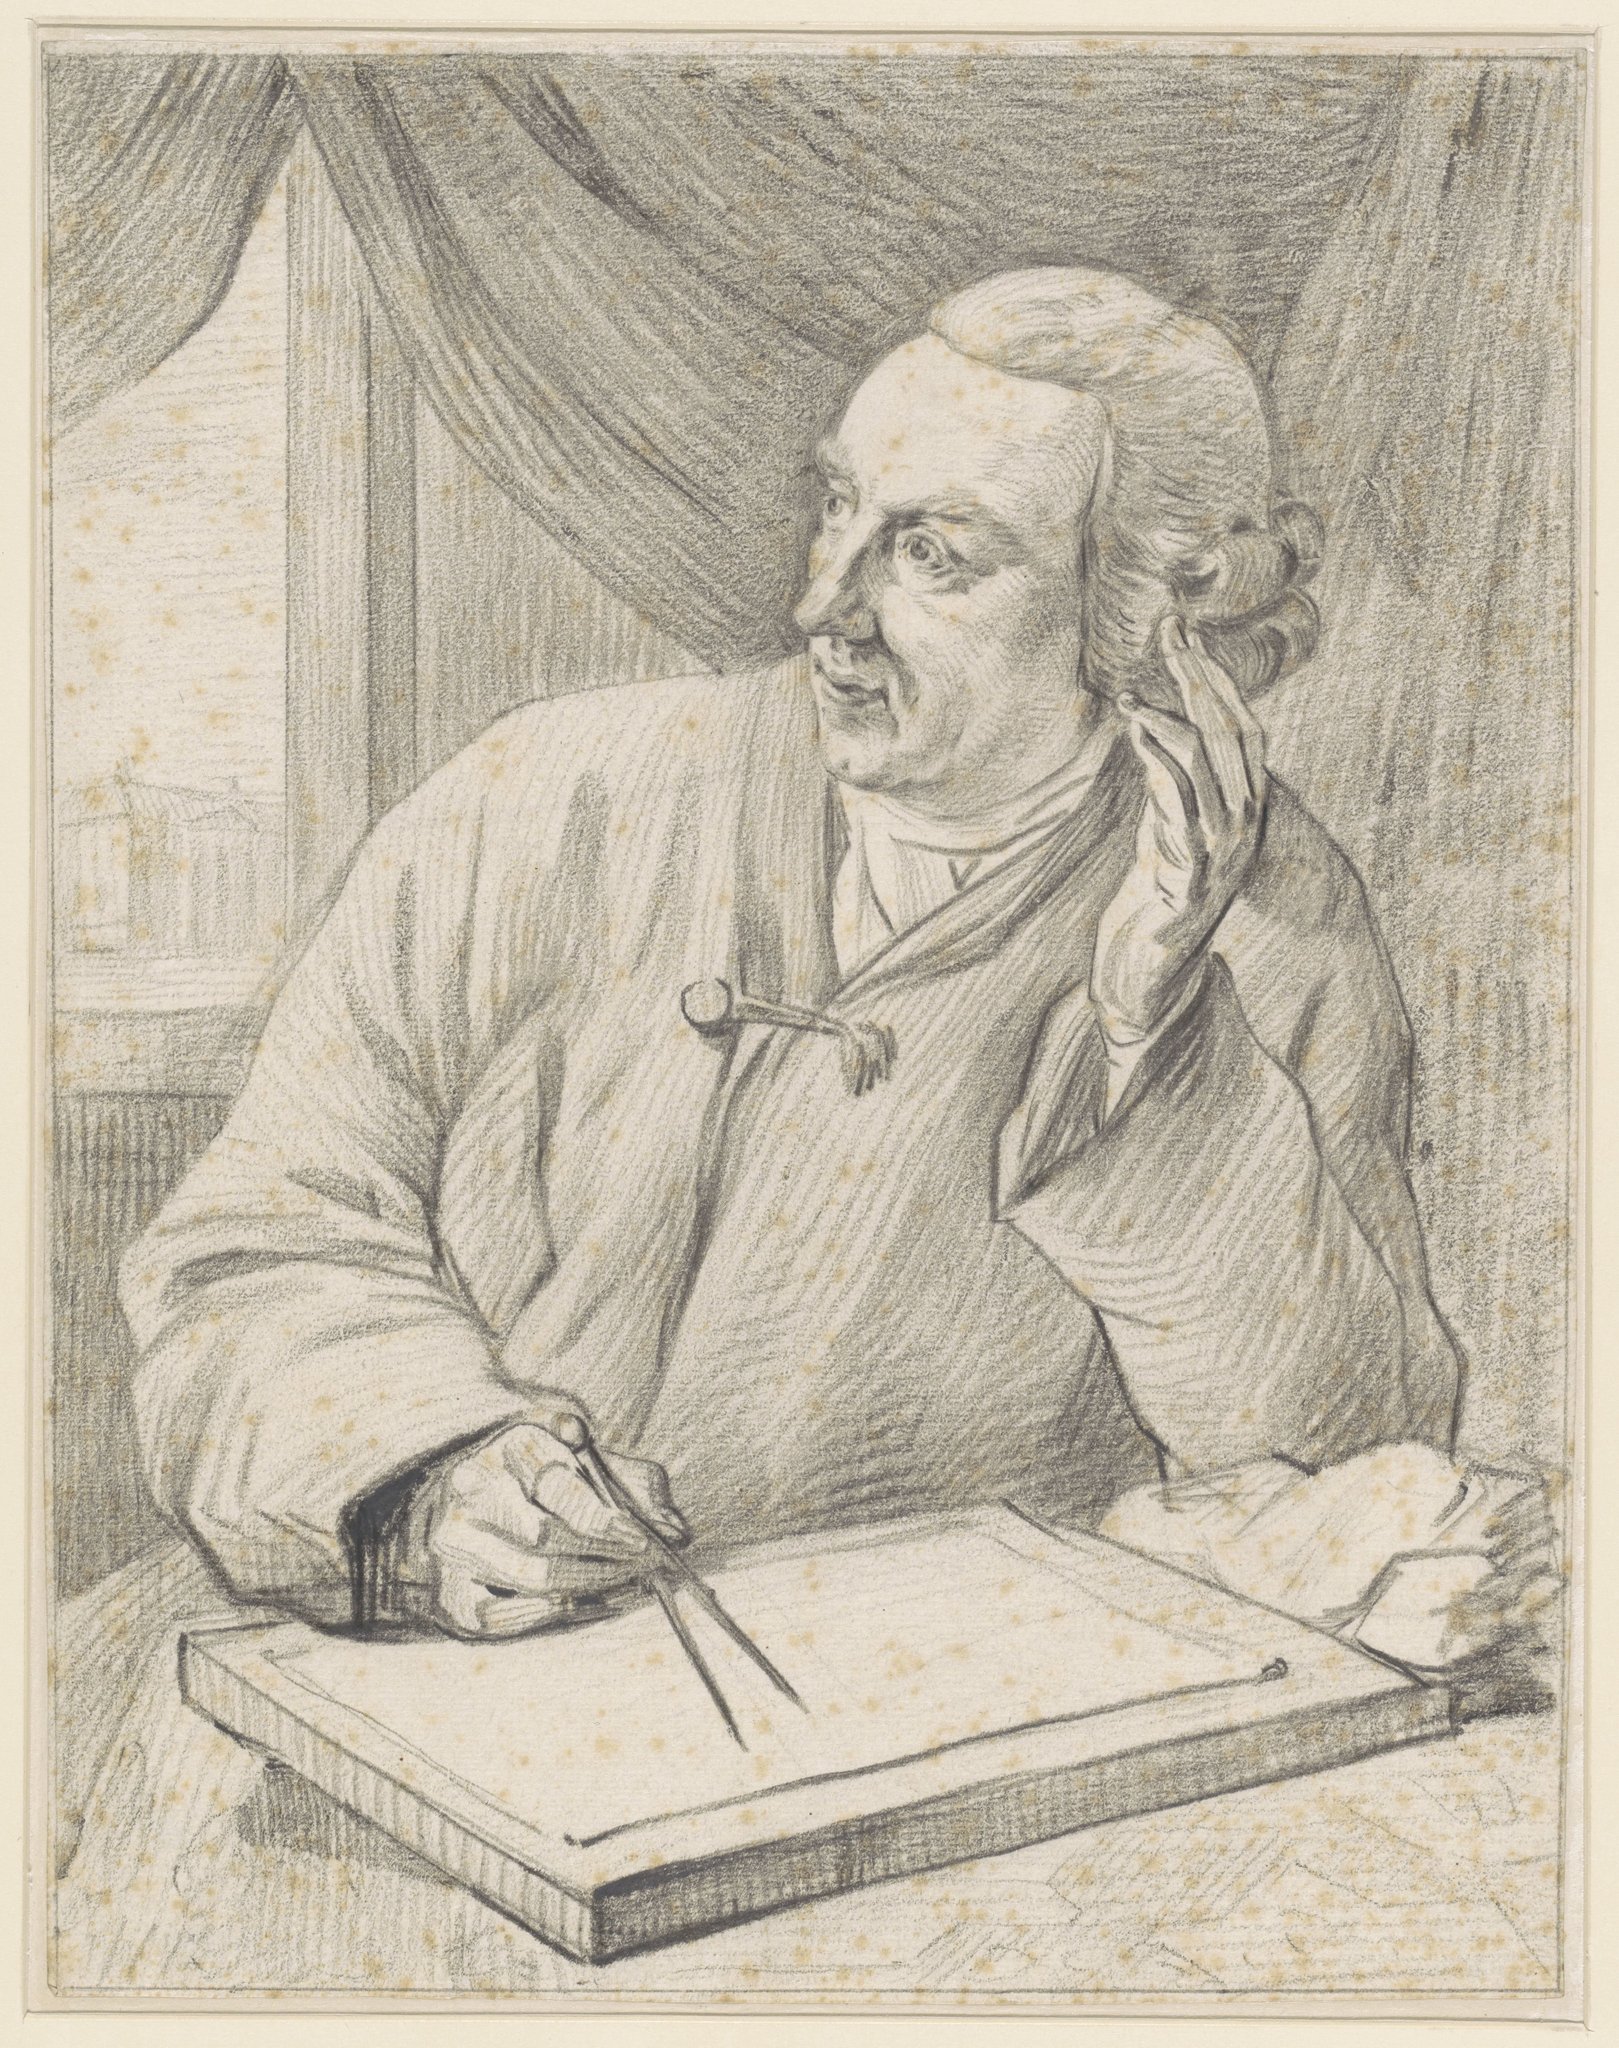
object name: drawing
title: Portret van (Hans) Jacob Otten Husly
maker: taco scheltema (i)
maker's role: draughtsman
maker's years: 1760-1837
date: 1780-1837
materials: chalk, paper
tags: jacob otten huslij, historical persons, portrait, self-portrait of painter, portrait, self-portrait of artist, portrait, self-portrait of draughtsman